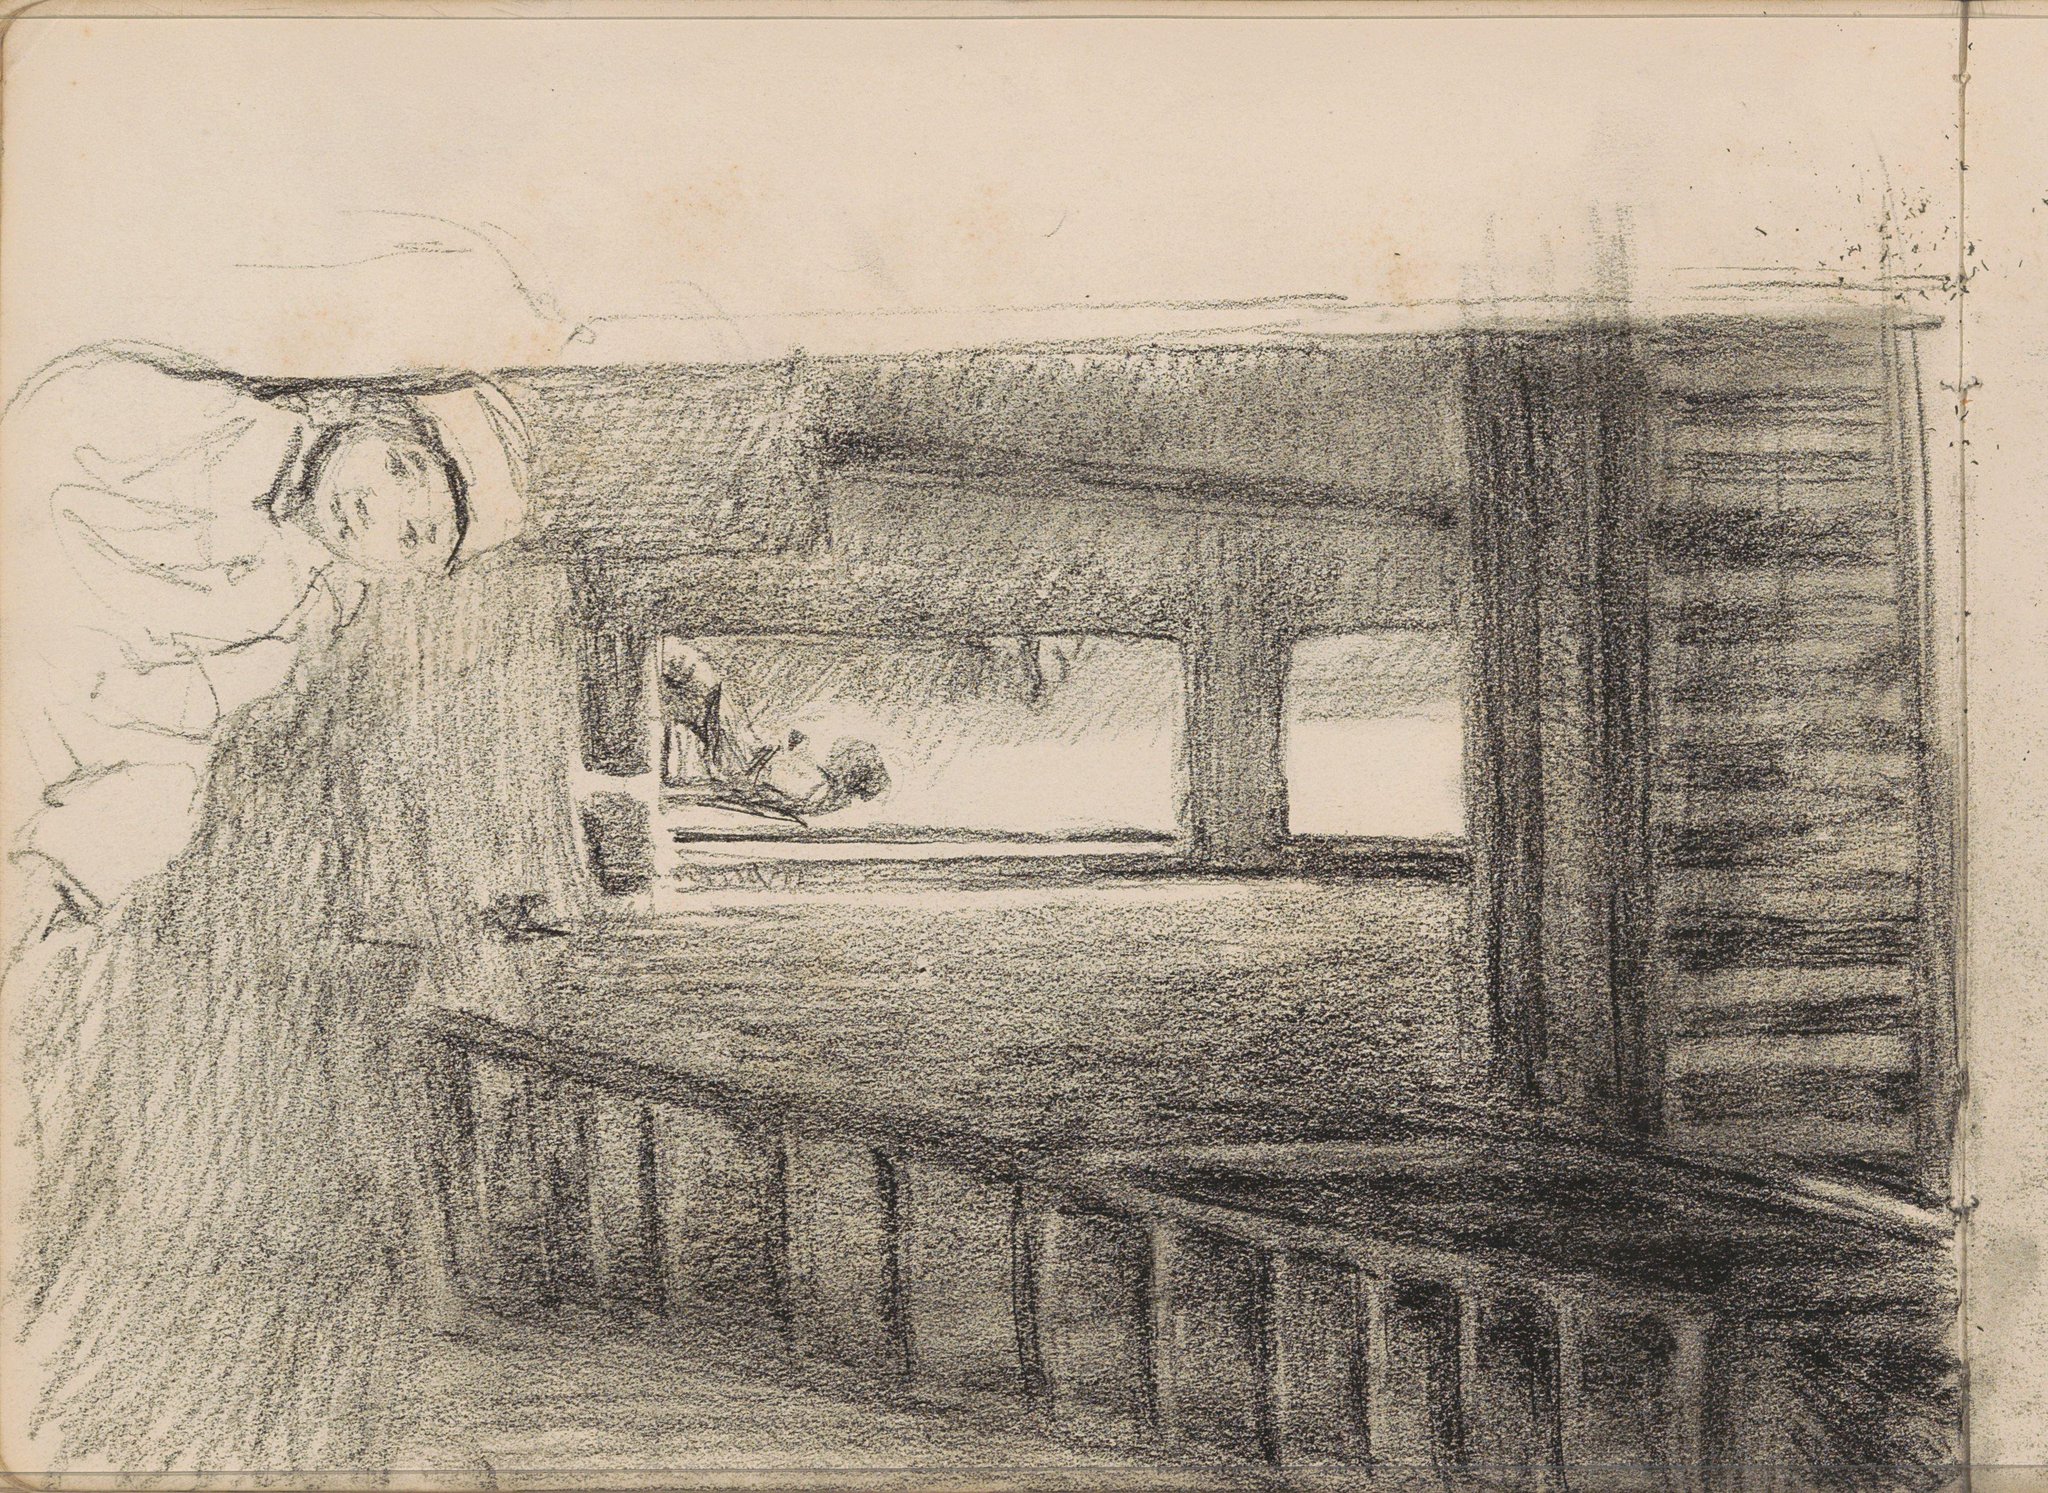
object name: sketchbook leaf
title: Zittende jongen in een interieur met een ladder naar een vide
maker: a.a.l. de grammont-hubrecht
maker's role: draughtsman, painter, print maker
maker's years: 1855-1913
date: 1865-1913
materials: chalk, paper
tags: sitting figure, boy (child between toddler and youth), interior of the house, fowl (cock, hen, chicken, etc.), ladder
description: Door een deuropening is een zittende figuur te zien. In het interieur scharrelt een kip. Blad 37 verso uit een schetsboek met 39 bladen.